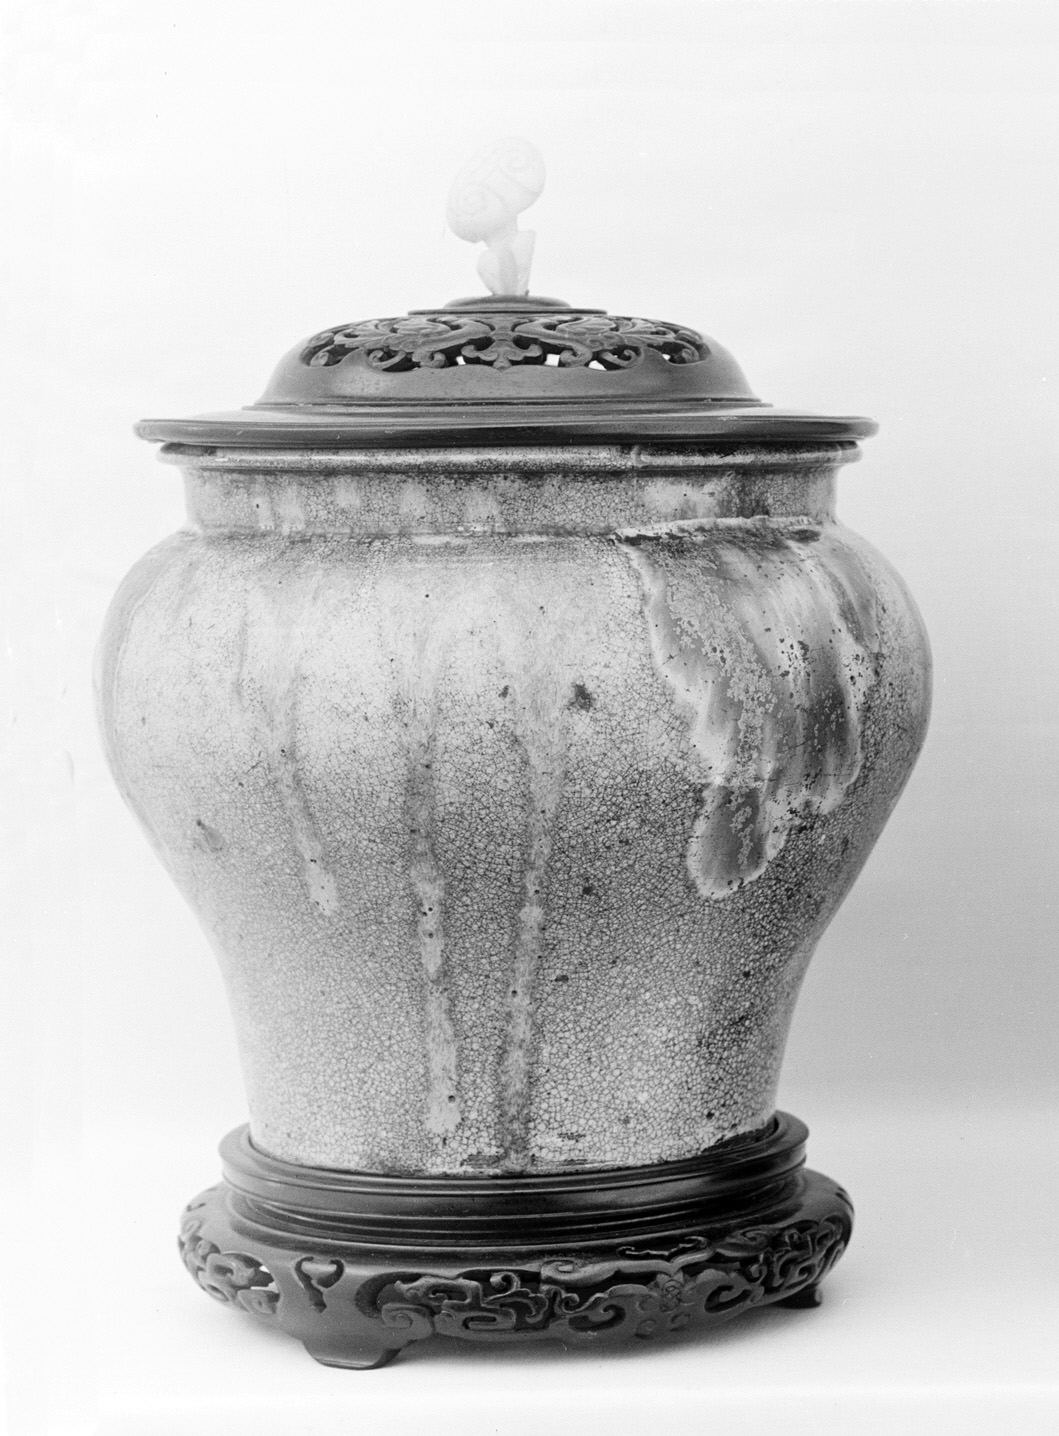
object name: jar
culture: japanese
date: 1701-1800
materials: clay, glaze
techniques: overglaze